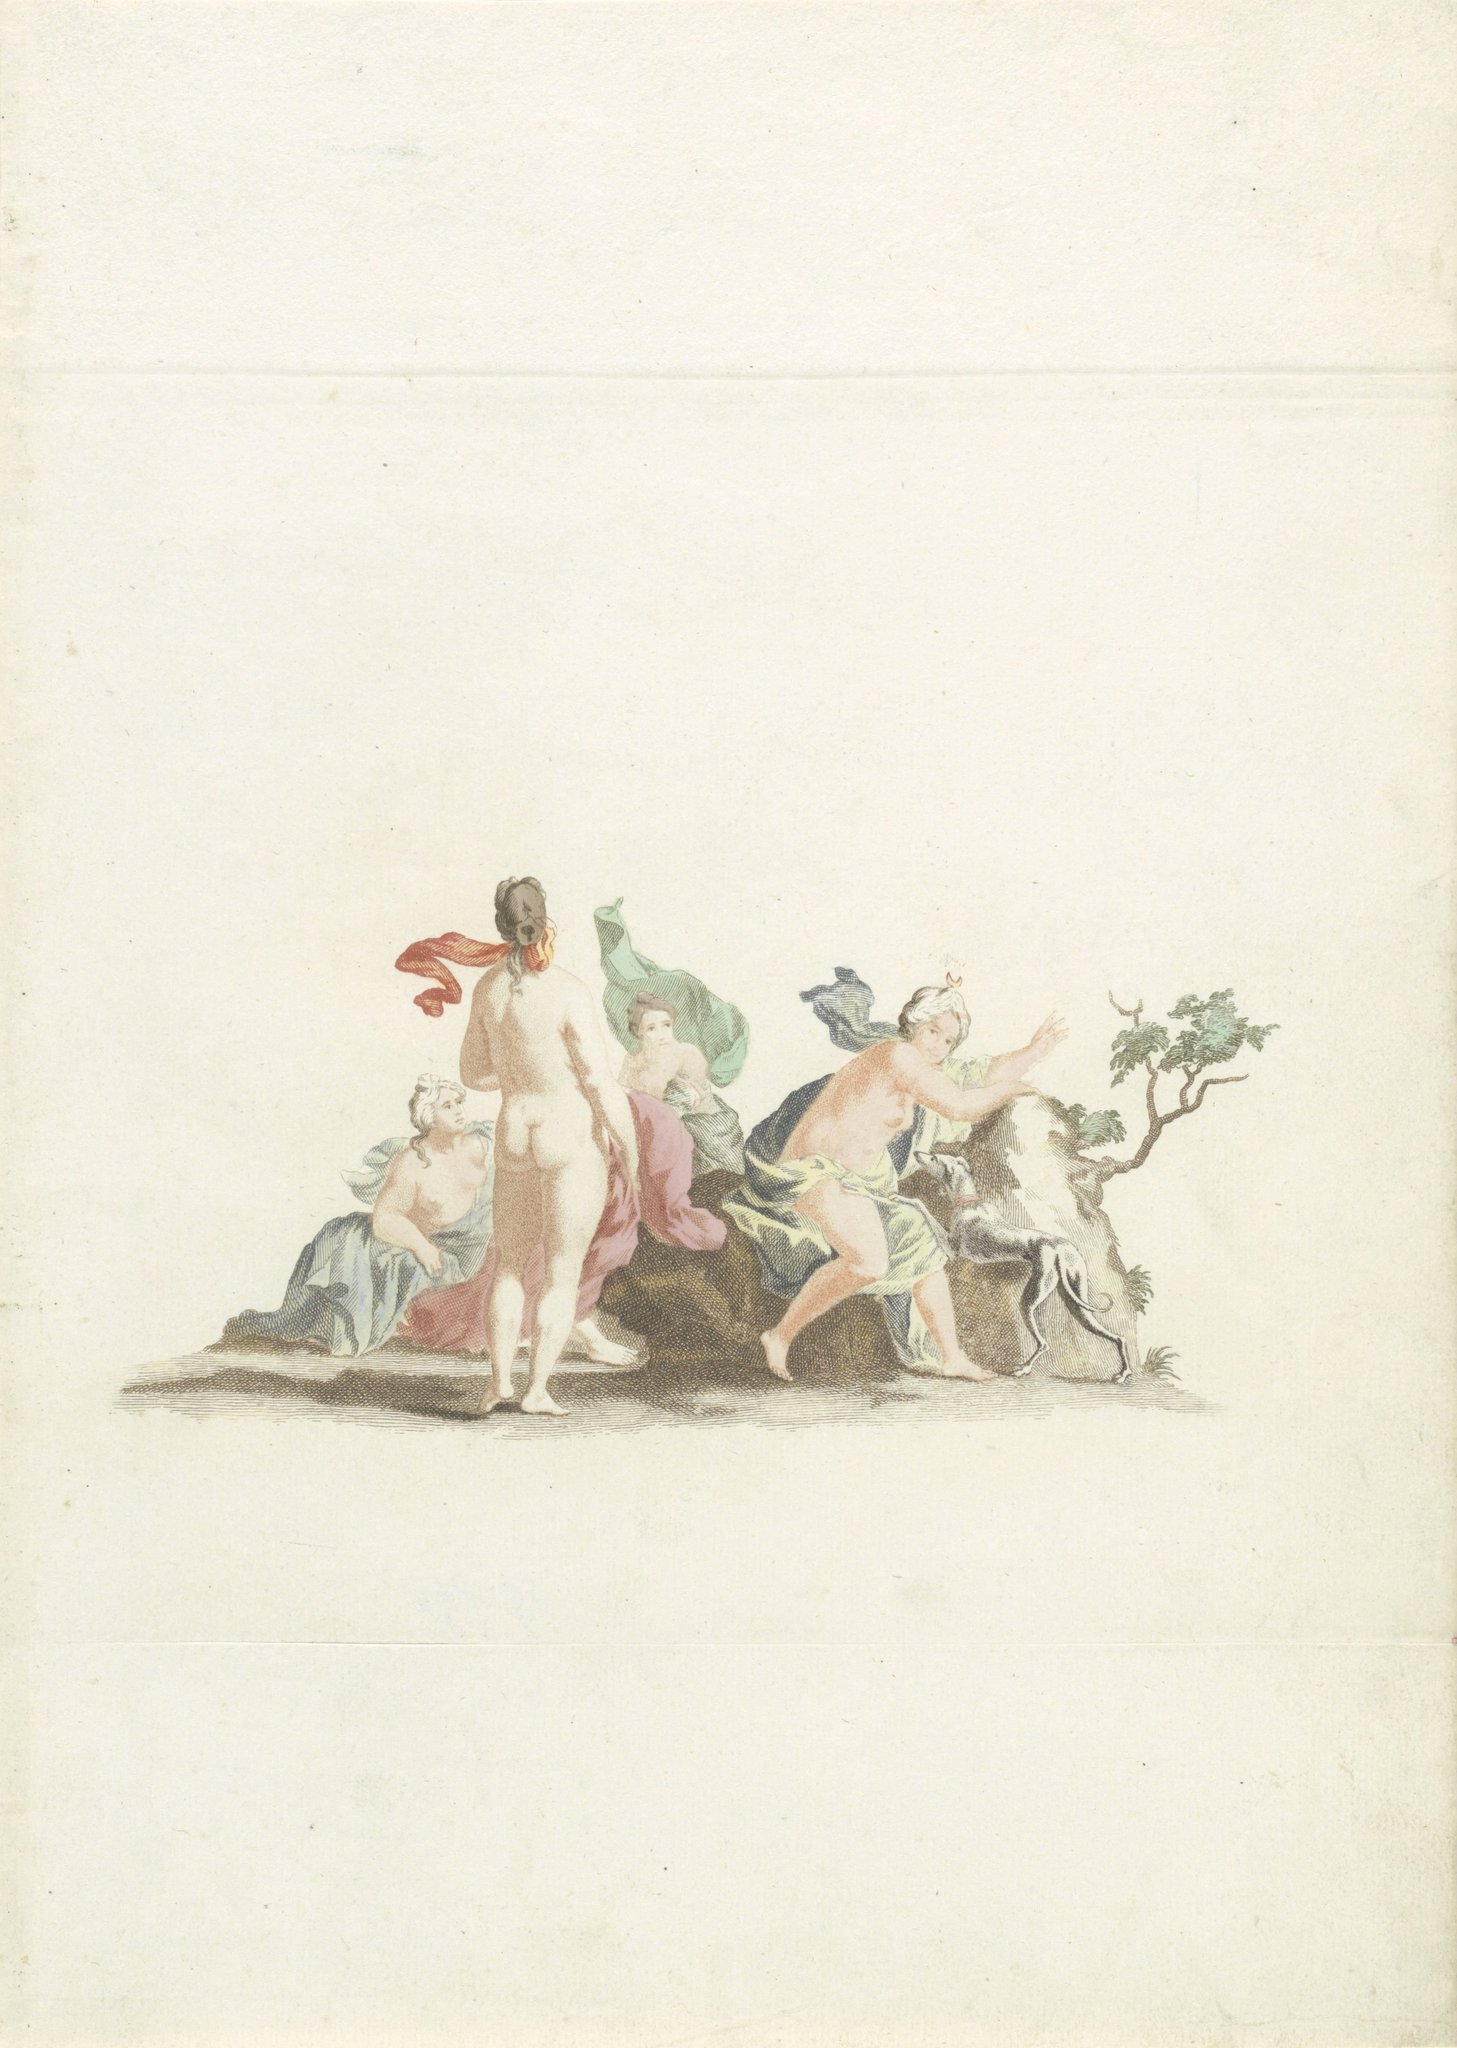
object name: print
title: Diana en haar nimfen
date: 1688-1698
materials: paper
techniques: printing, engraving, hand coloring, lithography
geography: netherlands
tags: companions, nymphs of diana; 'ninfe di diana' (ripa), (story of) diana (artemis)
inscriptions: collector's mark: Lugt 2228, collector's mark: Lugt 2760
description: Diana, maangodin en godin van de jacht, met een jachthond. Naast haar drie nimfen.